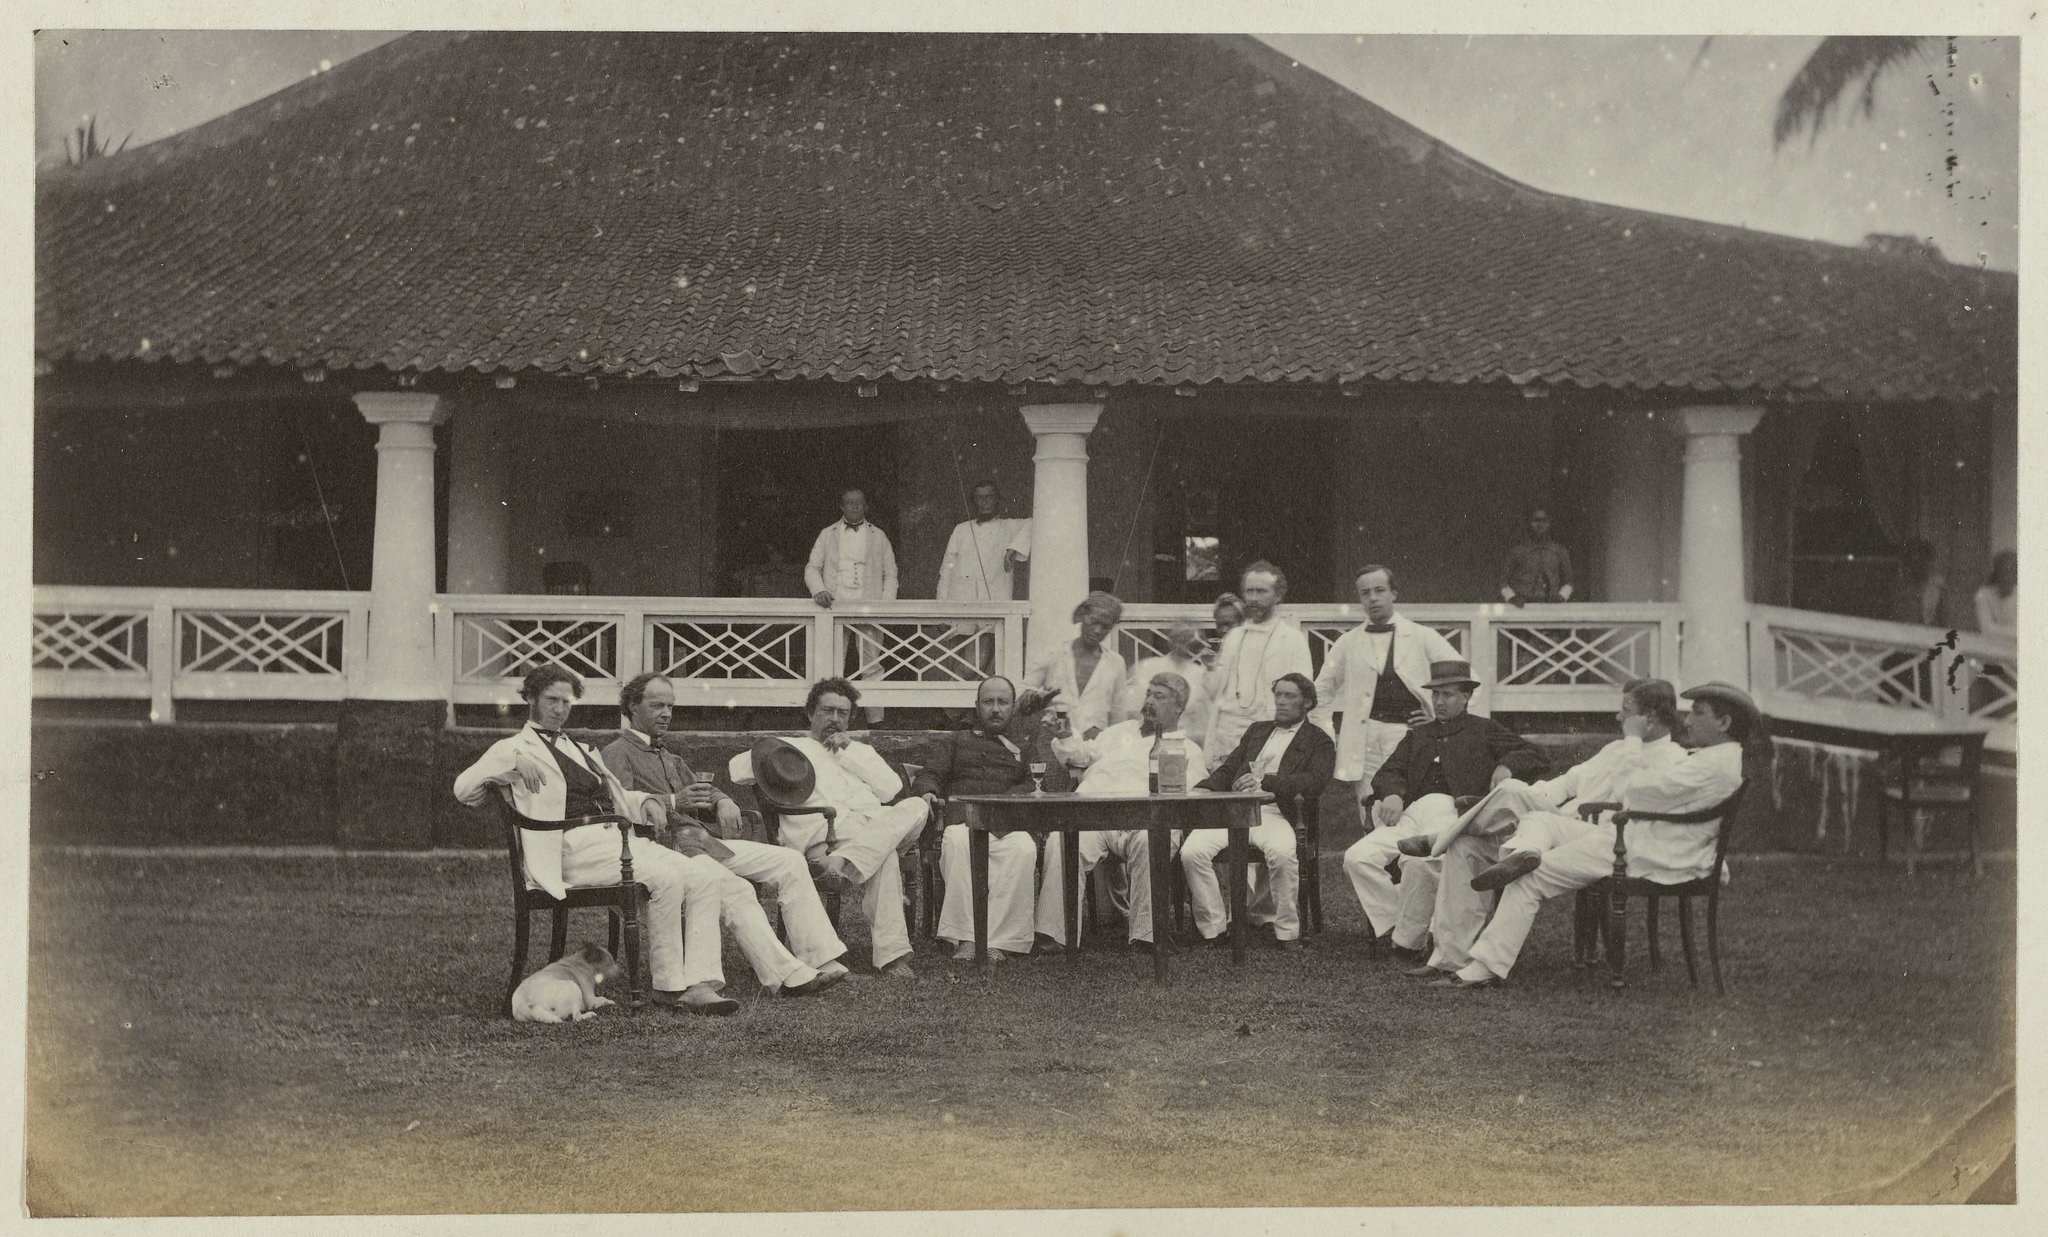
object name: photograph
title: Sociëteit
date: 1863-1869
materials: photographic support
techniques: albumen print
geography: java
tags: club, meeting place, java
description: Groep mannen op stoelen rond een tafel in de tuin van een sociëteit. Onderdeel van het groene fotoalbum met foto's van Java, uit het bezit van apotheker Specht-Grijp, die in 1865 vanuit Batavia naar Nederland terugkeerde.